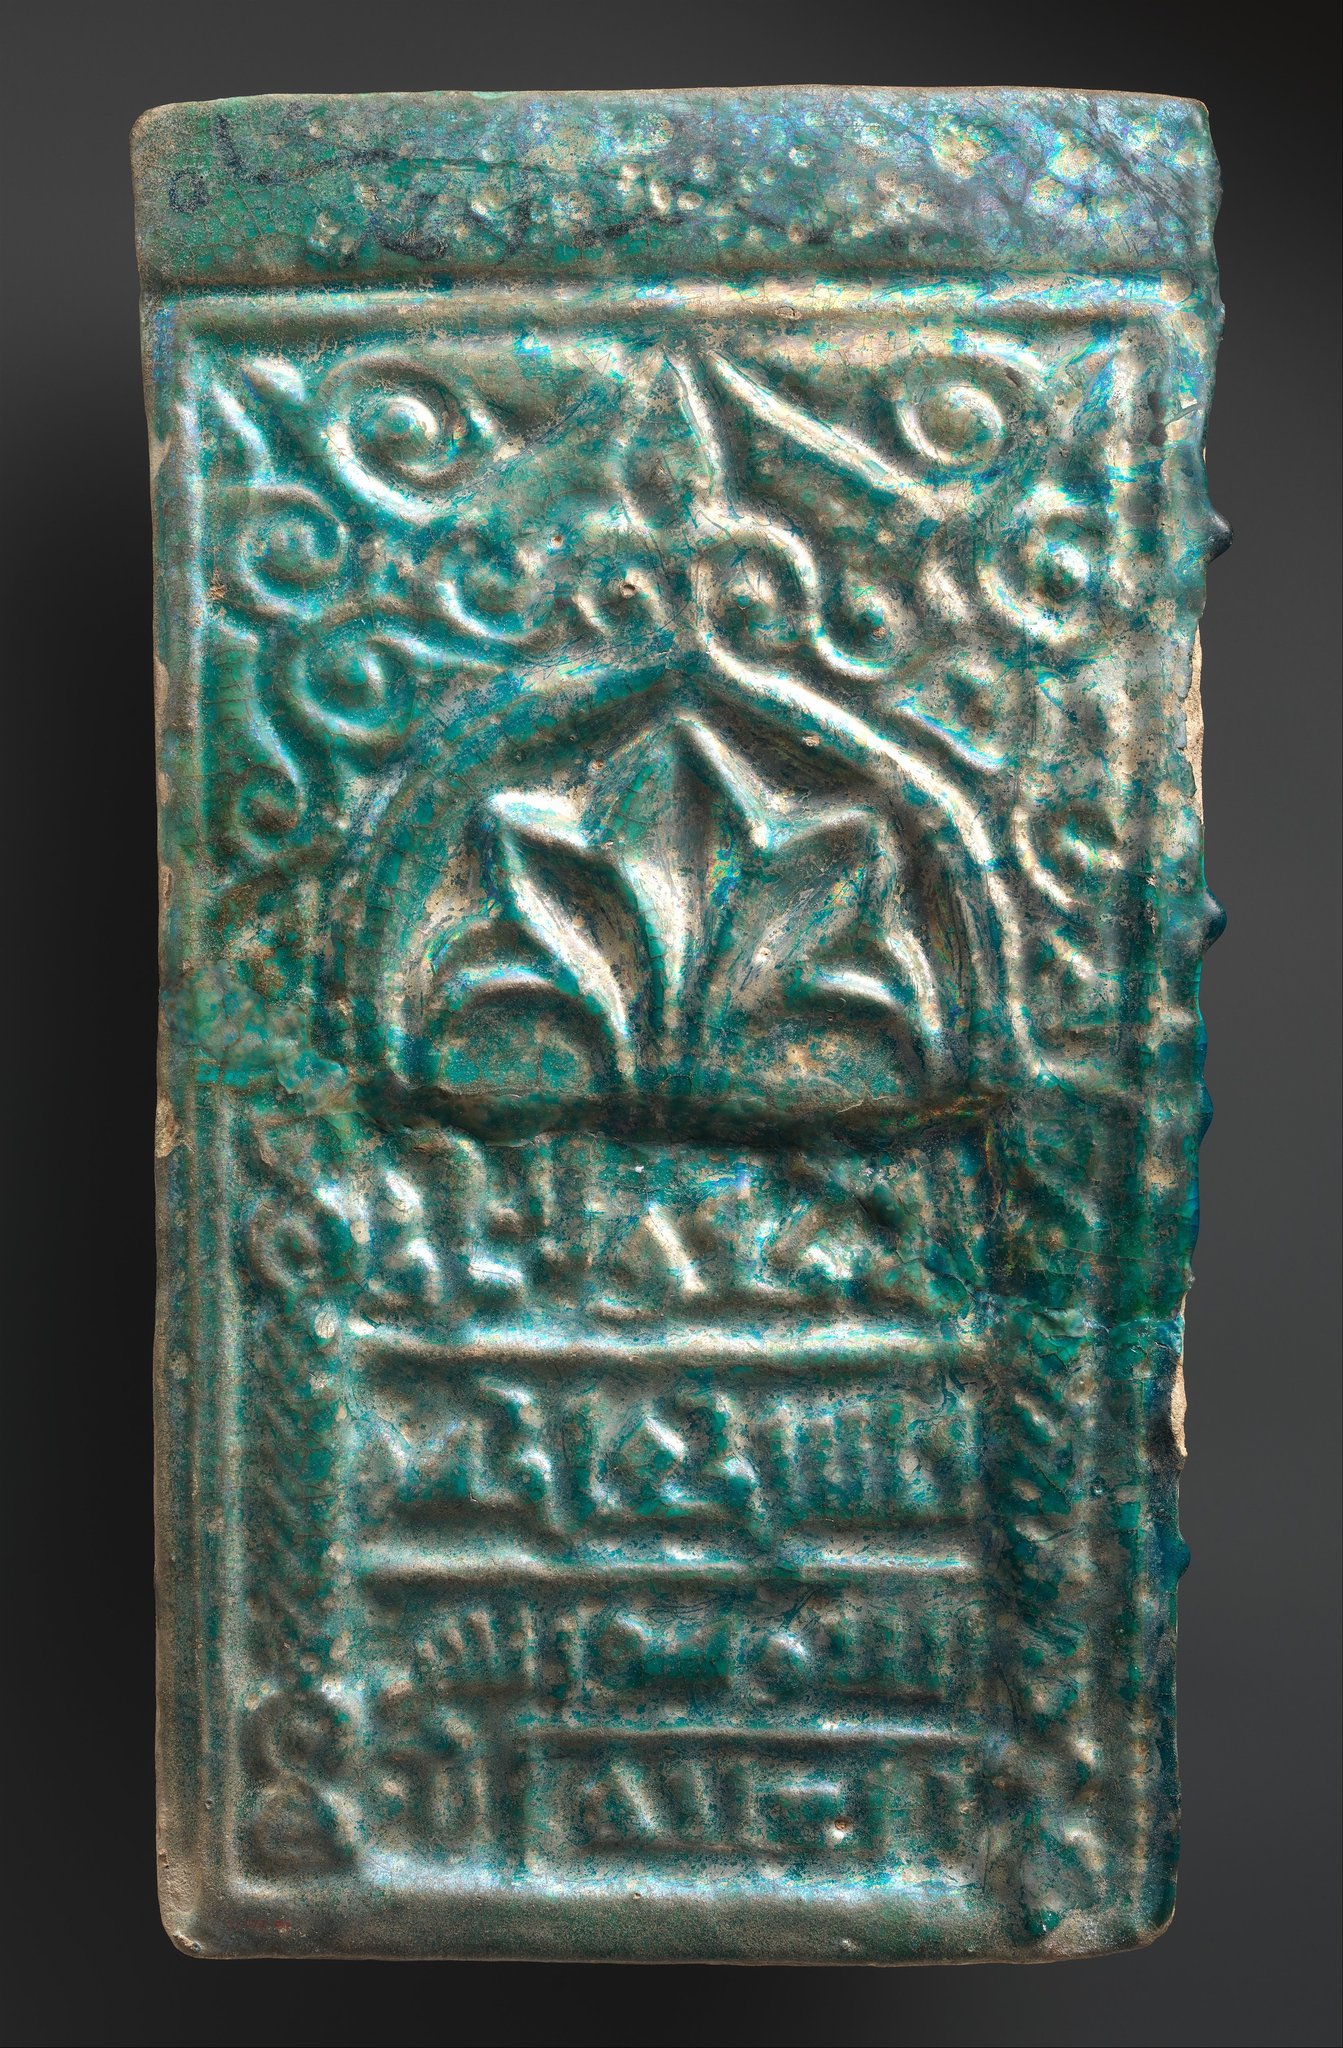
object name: tile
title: Tile with Niche Design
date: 1101-1200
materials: stonepaste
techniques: glazing, molding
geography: jazira